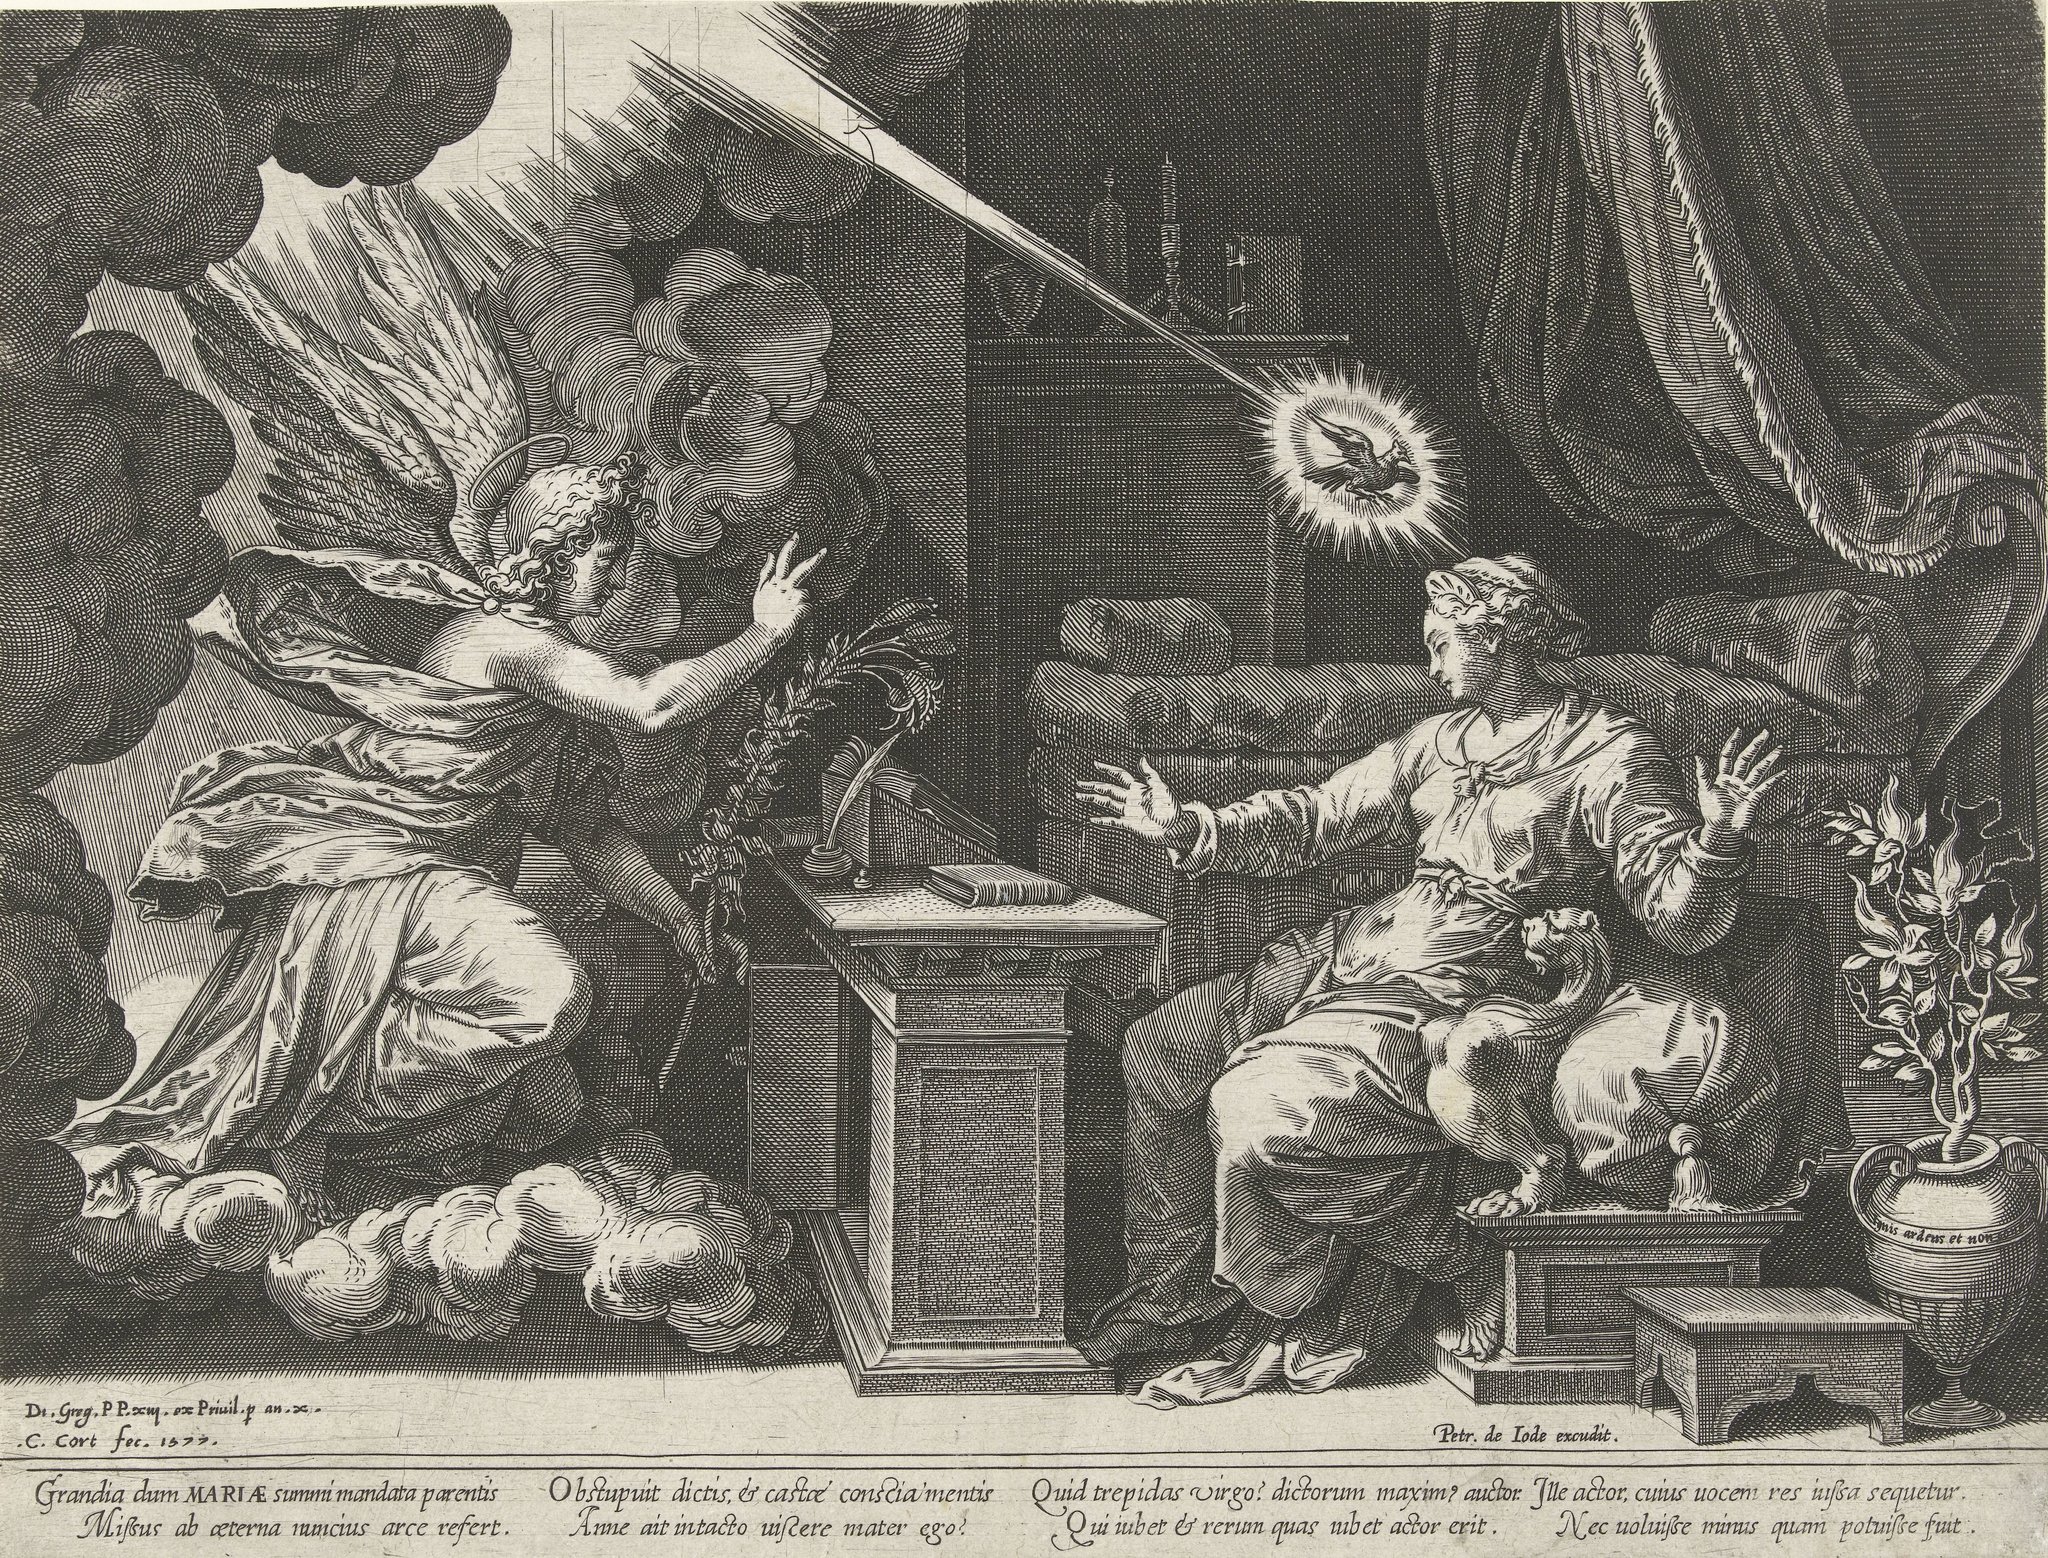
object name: print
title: Annunciatie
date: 1577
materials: paper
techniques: engraving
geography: antwerp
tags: mary (alone) reading, praying, etc. ~ annunciation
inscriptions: inscription: ‘Ignis ardens et non Conburens’, collector's mark: Lugt 2228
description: Maria zit met gesloten ogen en uitgestrekte handen op een stoel in haar slaapkamer. Rechts een lelie in een vaas. De engel Gabriël komt om haar te verkondigen dat zij Christus zal baren. De Heilige Geest in de gedaante van een duif daalt op Maria neer.